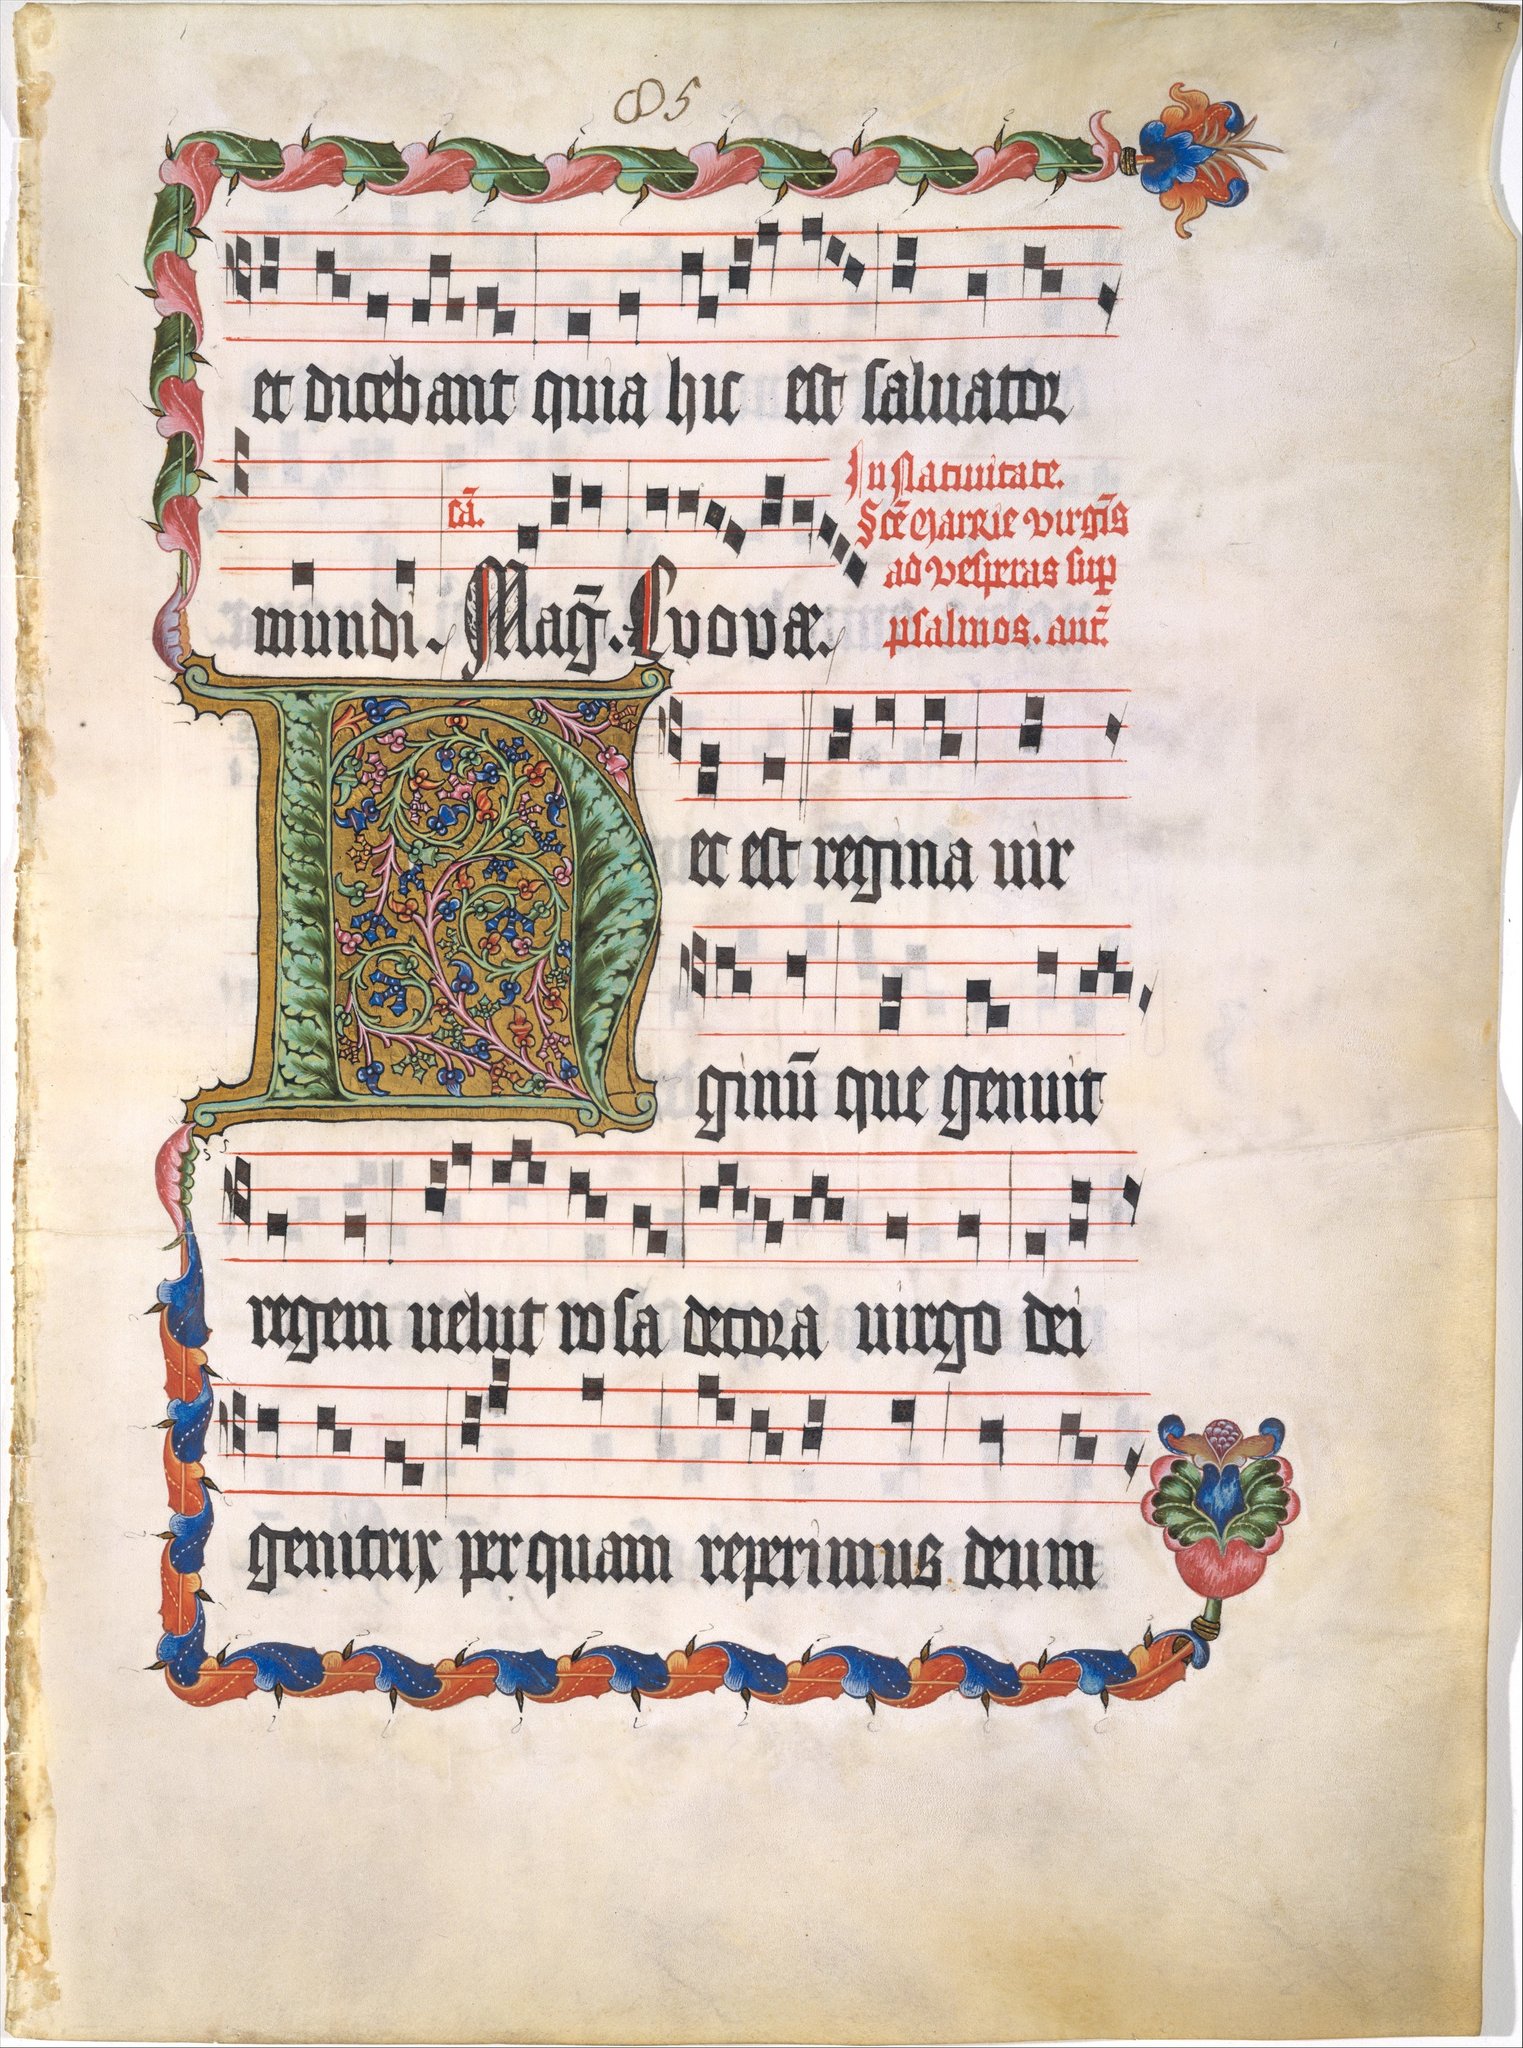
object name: antiphonary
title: Manuscript Leaf with Initial H, from an Antiphonary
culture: german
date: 1426-1450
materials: ink, metal leaf, parchment, paint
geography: germany